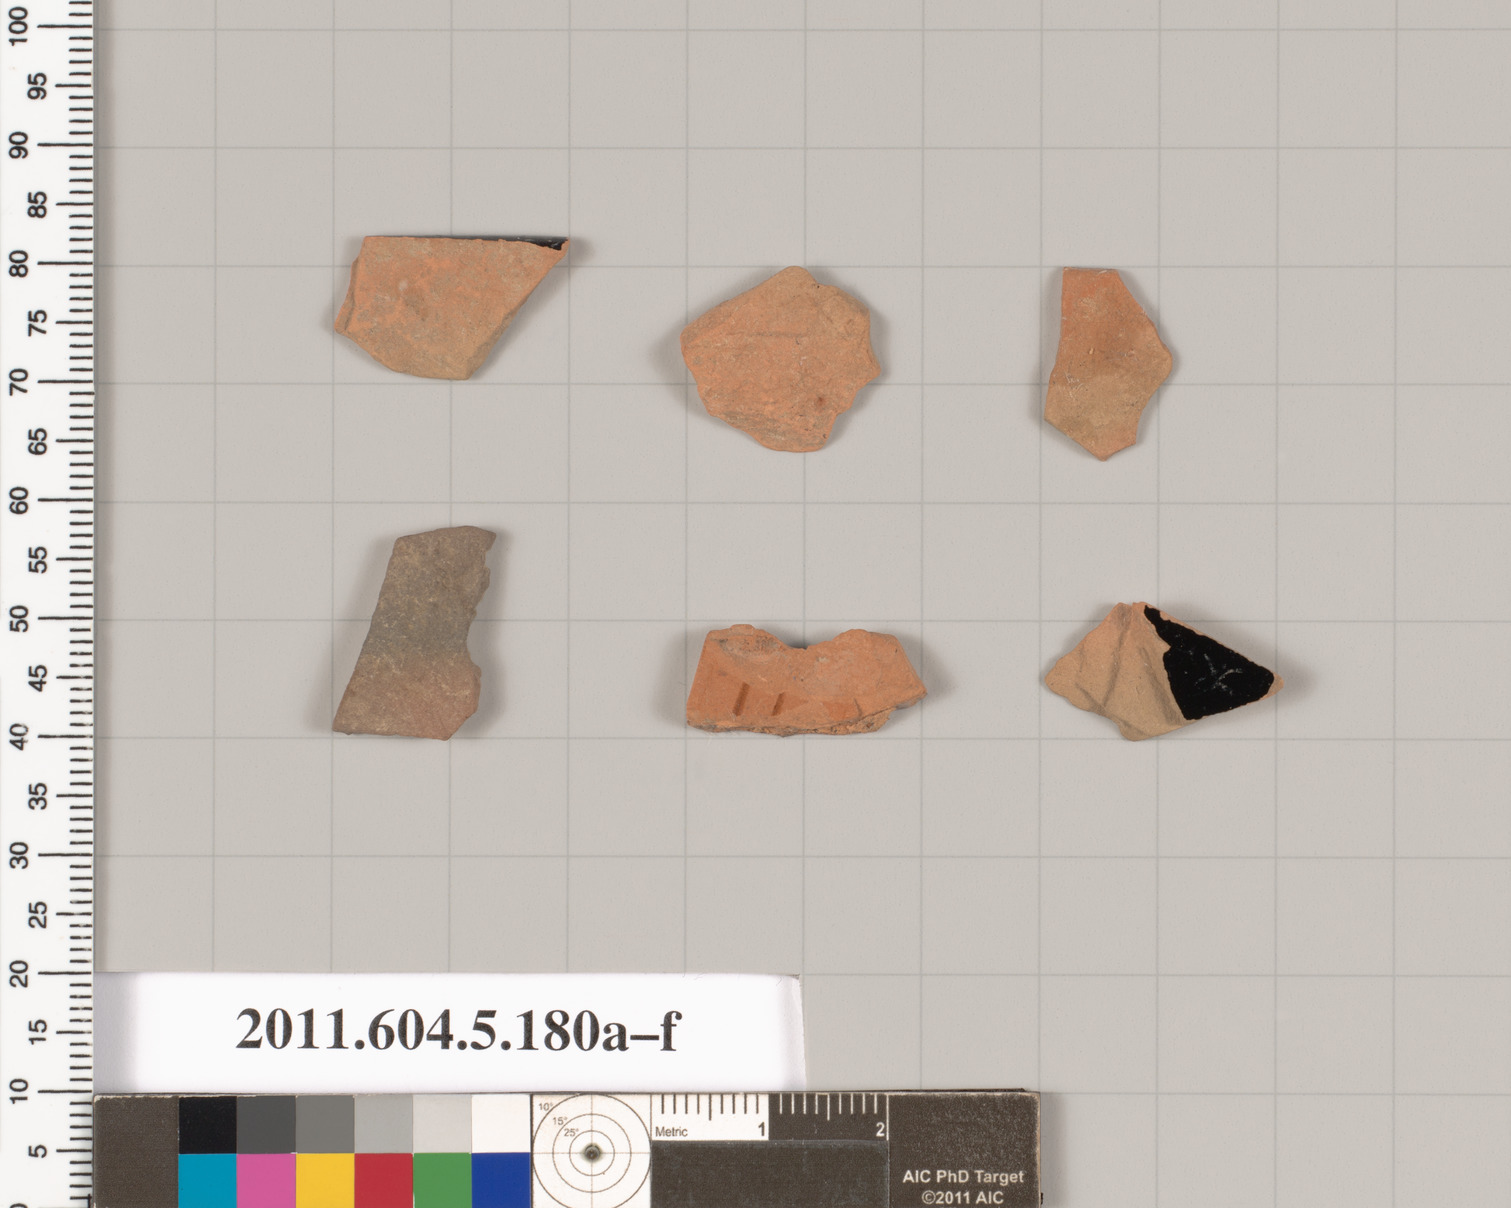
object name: kylix fragment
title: Terracotta fragments of kylikes (drinking cups)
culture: greek, attic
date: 600-401 BCE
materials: terracotta